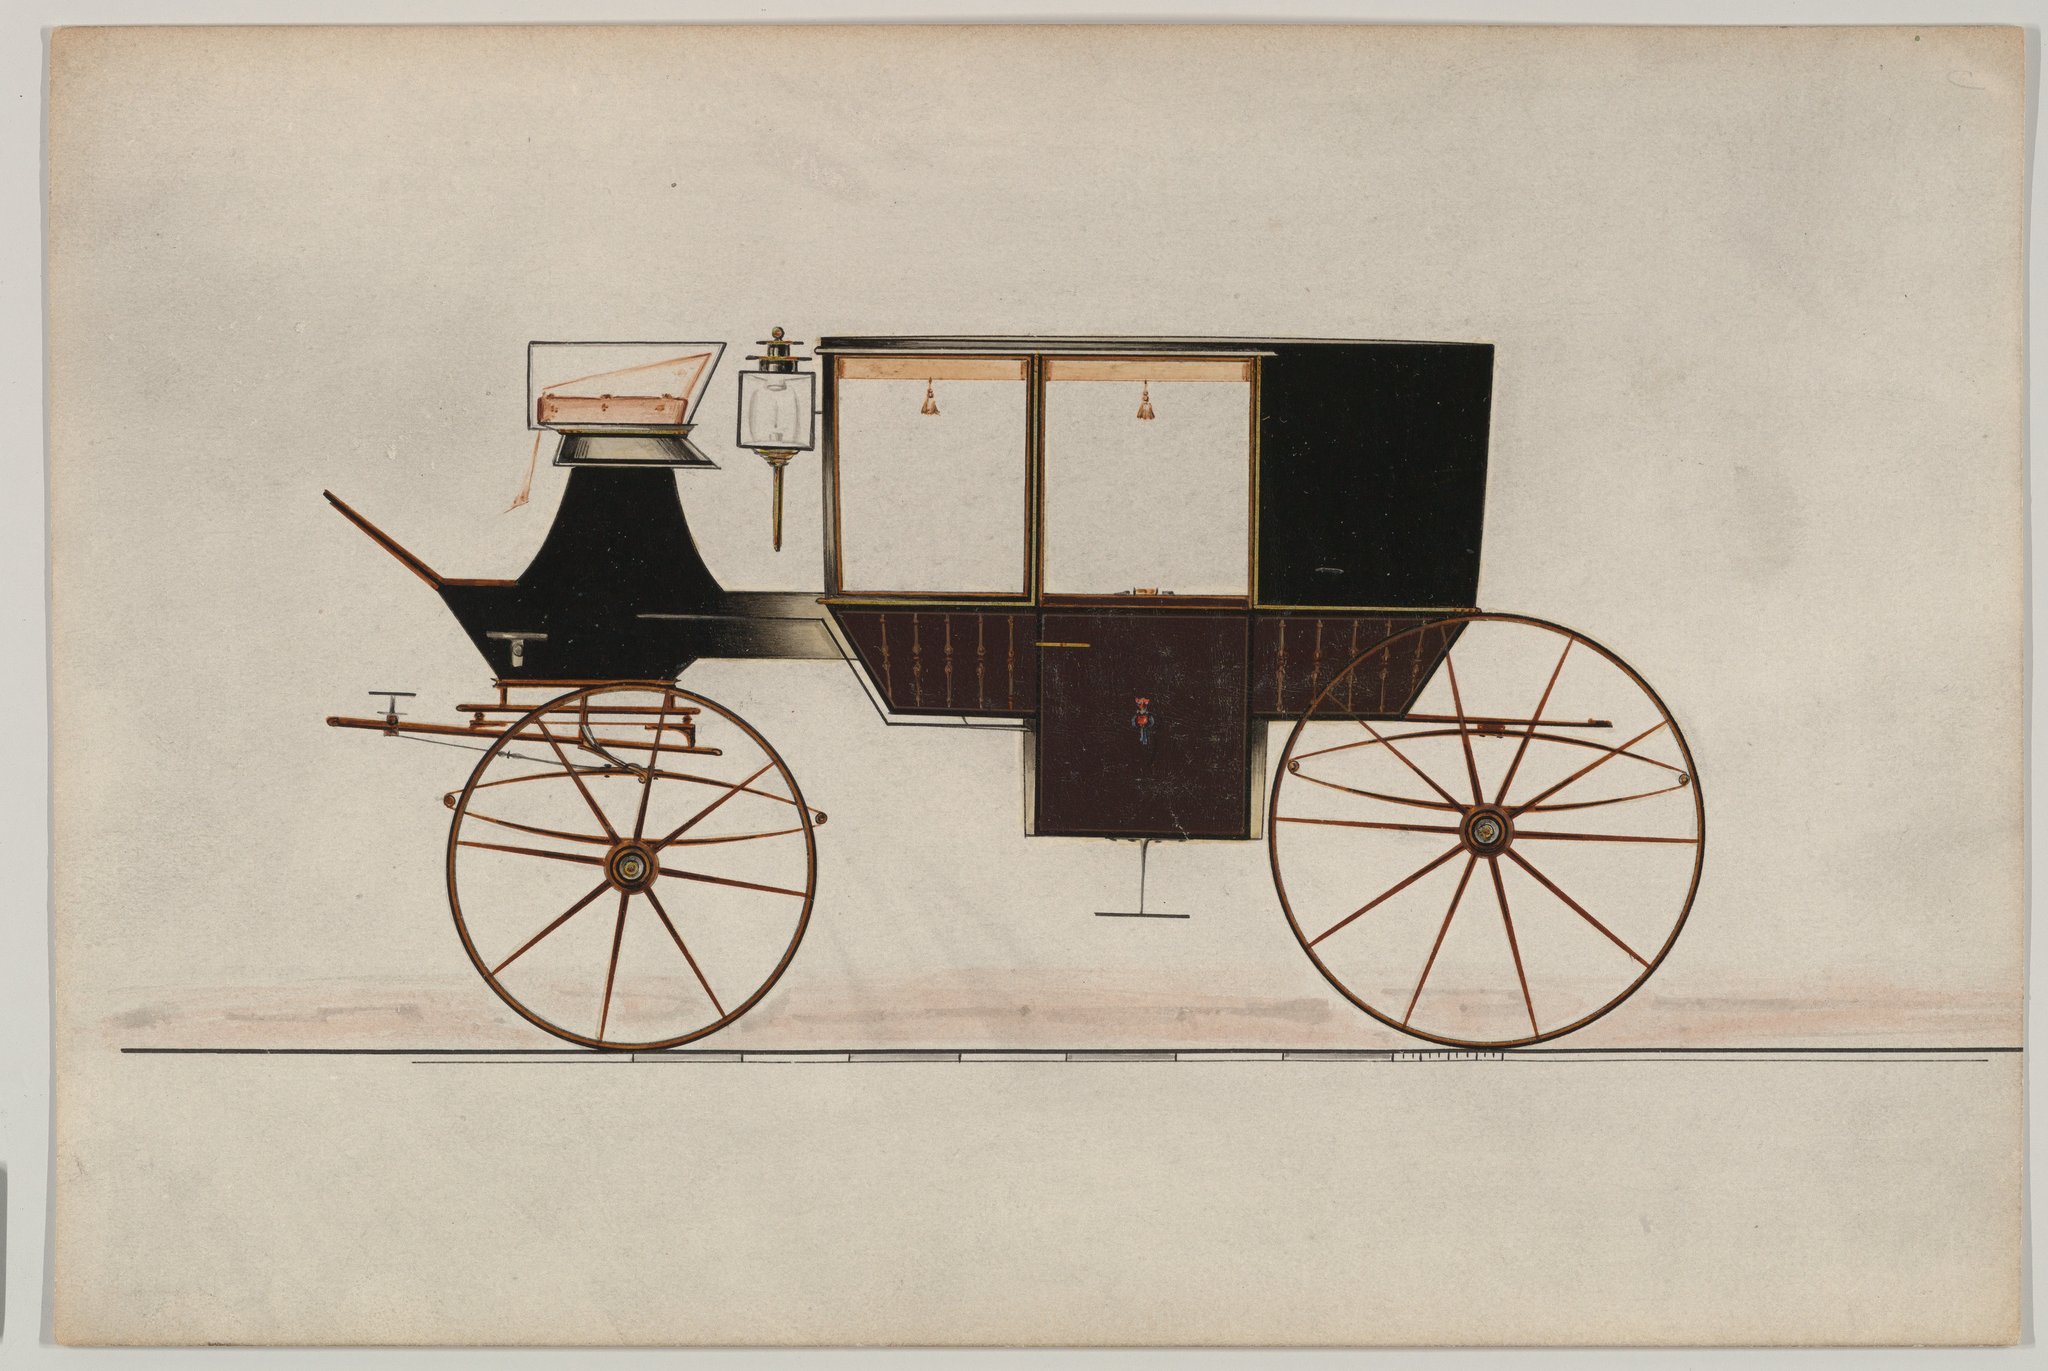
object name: drawing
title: Coach (unnumbered)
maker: brewster & co.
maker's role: manufacturer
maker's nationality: american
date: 1870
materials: gouache, gum arabic, ink, watercolor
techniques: pen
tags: carriages